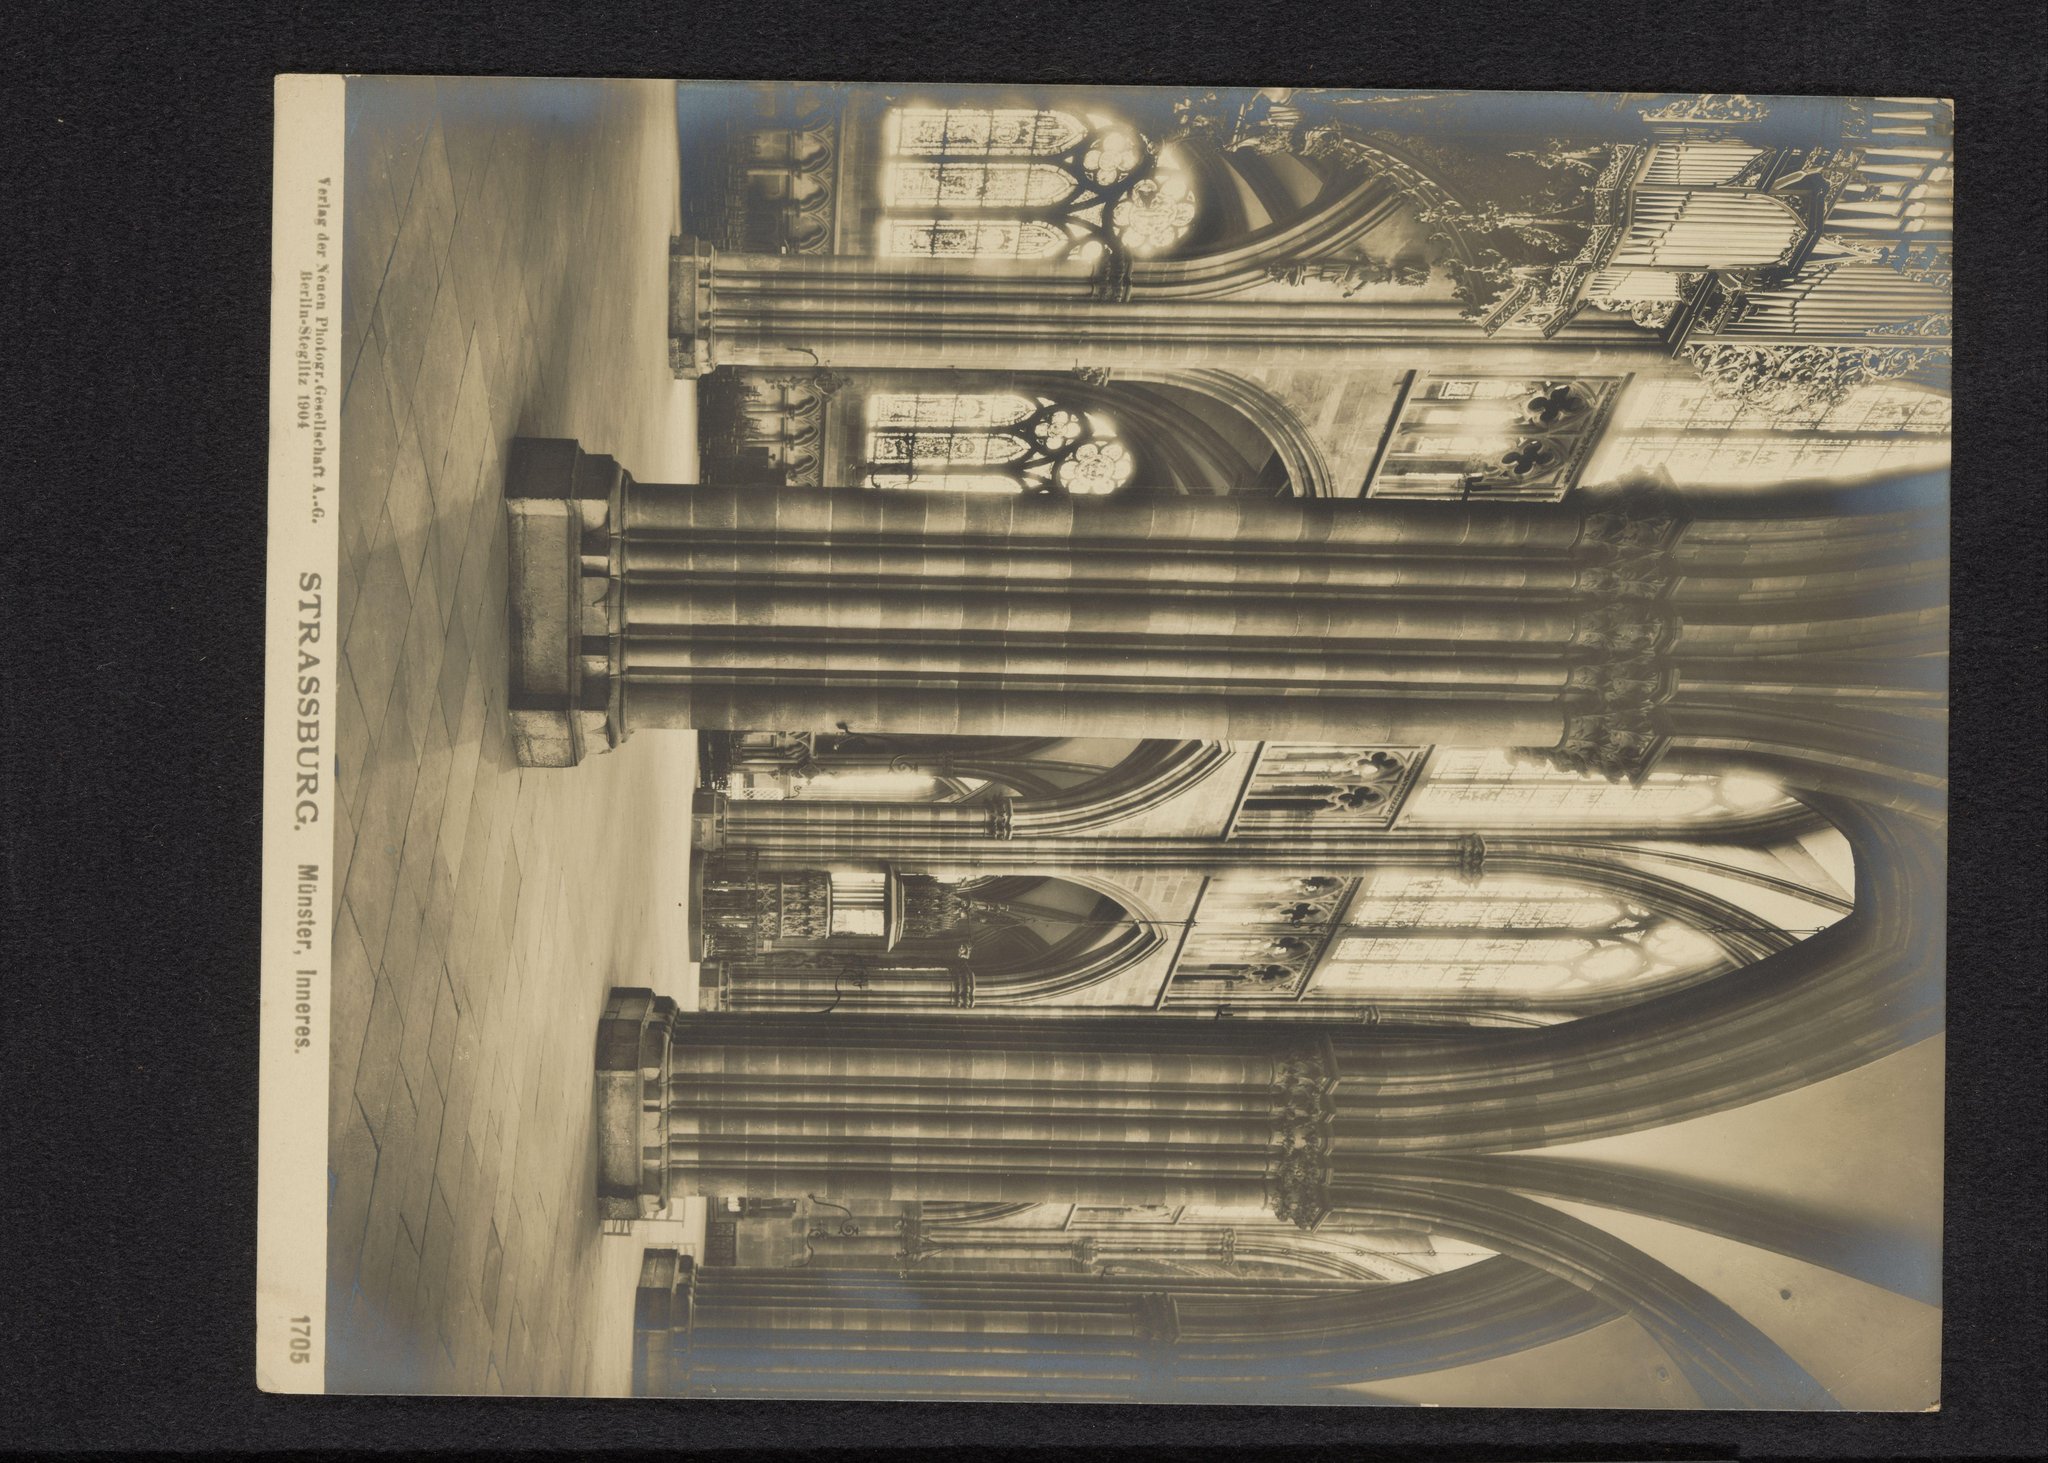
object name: photograph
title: Interieur van de kathedraal van Straatsburg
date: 1900-1911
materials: photographic support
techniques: gelatin silver print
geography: straatsburg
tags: interior of church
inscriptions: number: ‘1705’